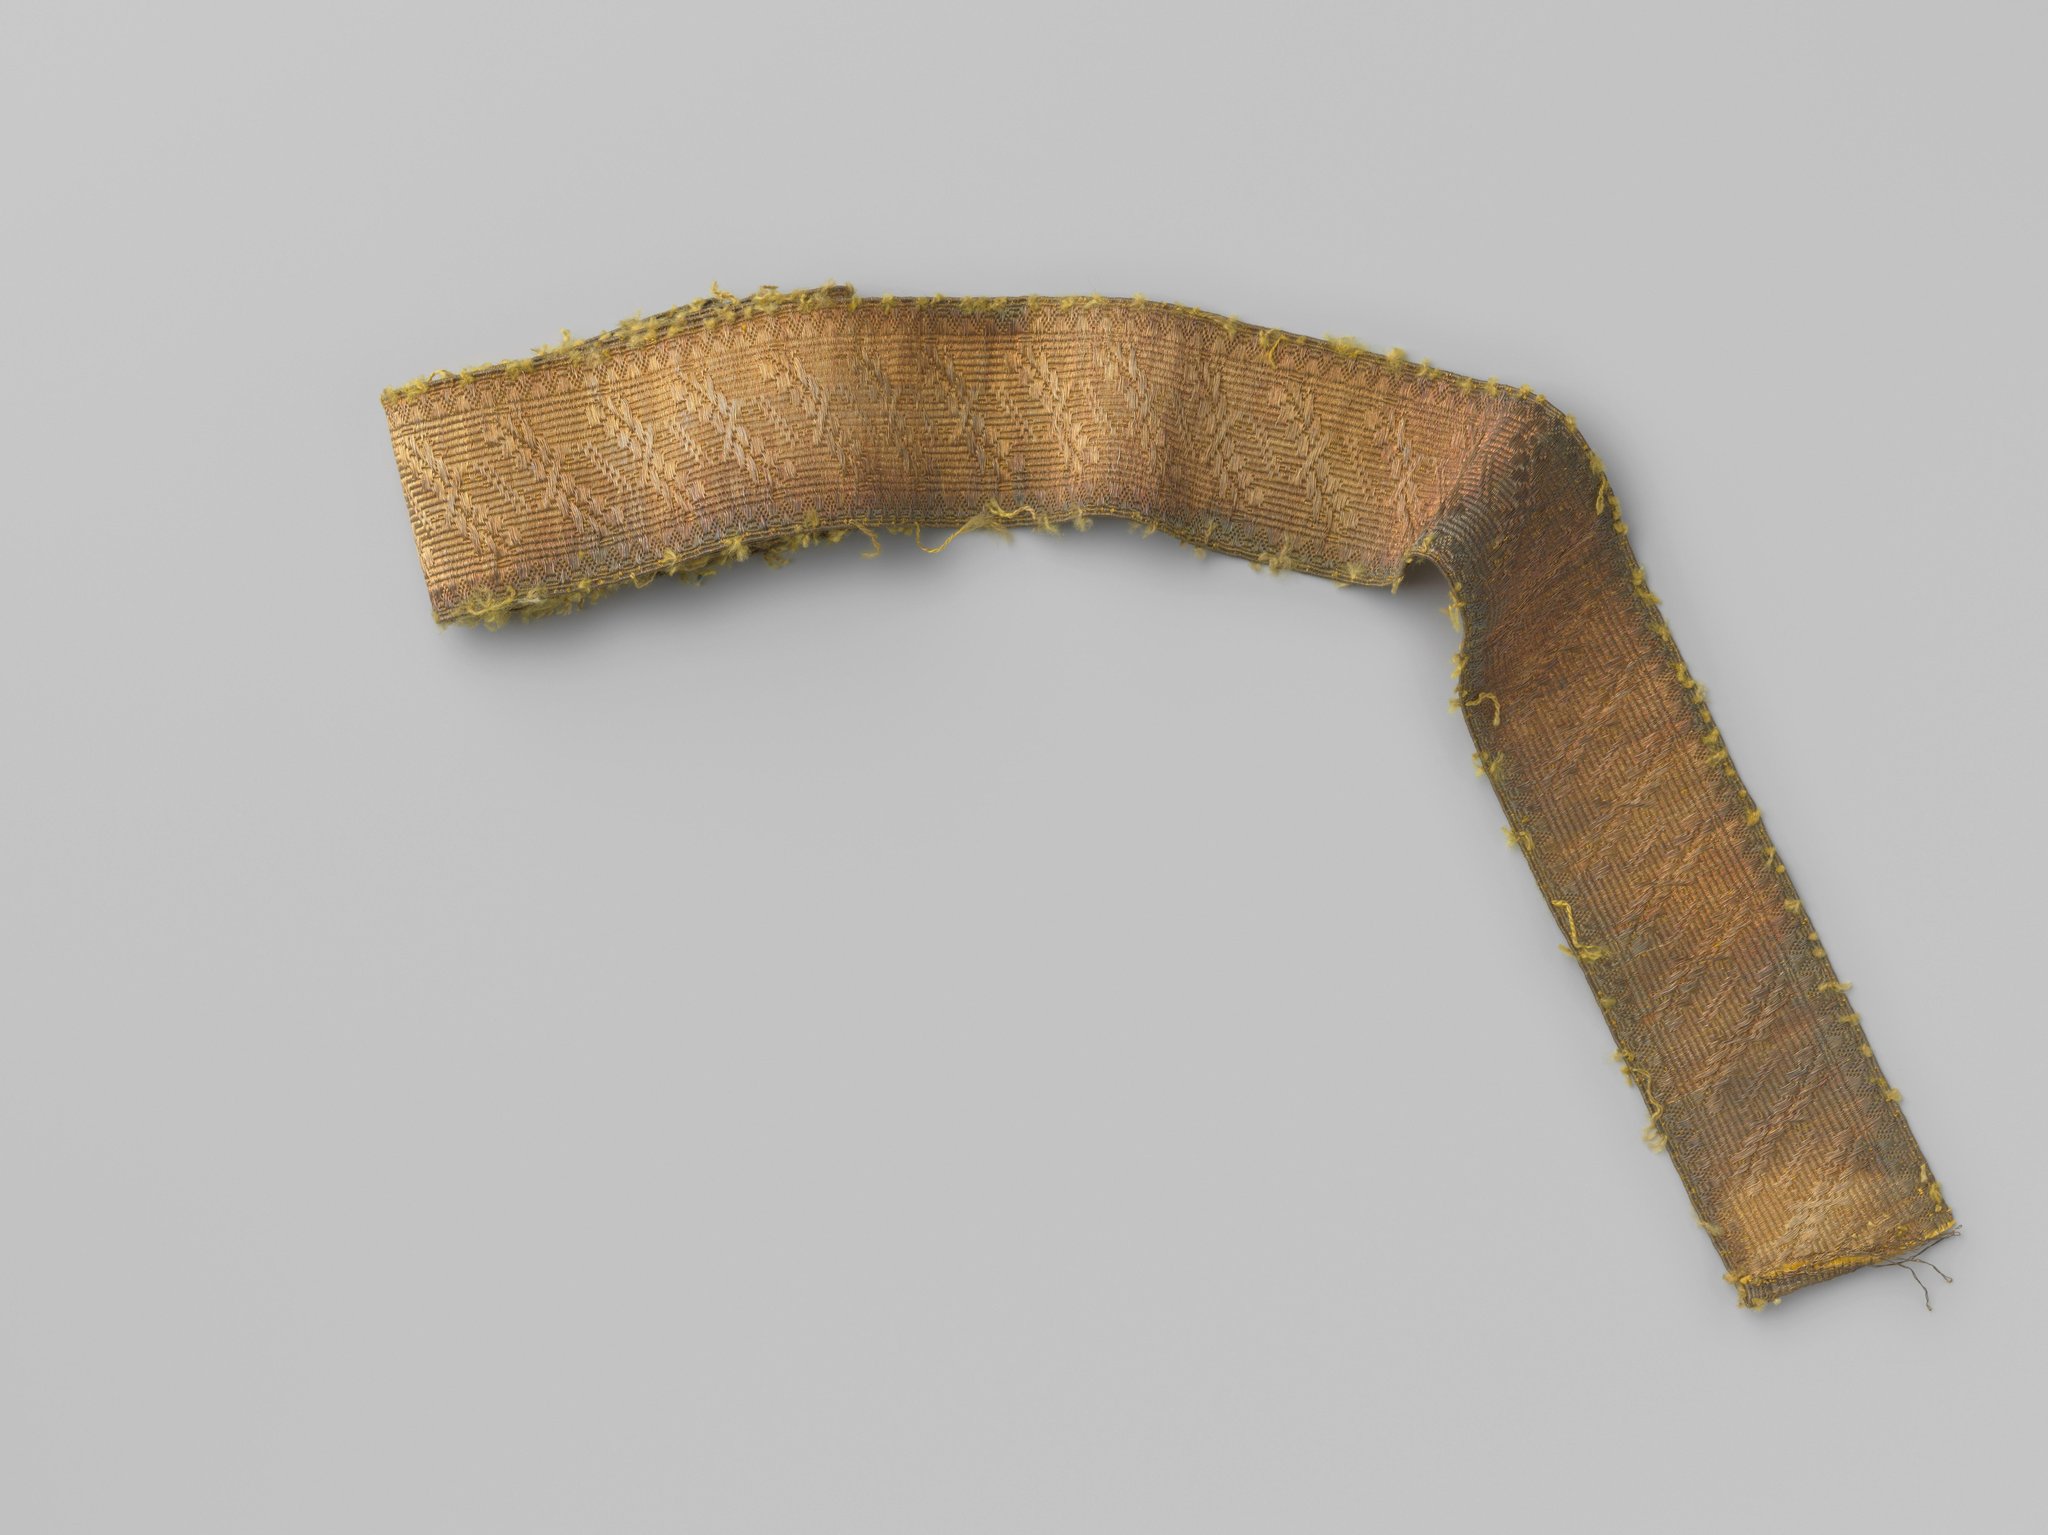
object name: goudgalon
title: Goudgalon voor broek van J.R. Thorbecke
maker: Anonymous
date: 1850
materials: textile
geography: netherlands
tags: the hague, johan rudolf thorbecke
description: Goudgalon voor broek behorende bij ambtskostuum van J.R. Thorbecke als minister van Binnenlandse Zaken.